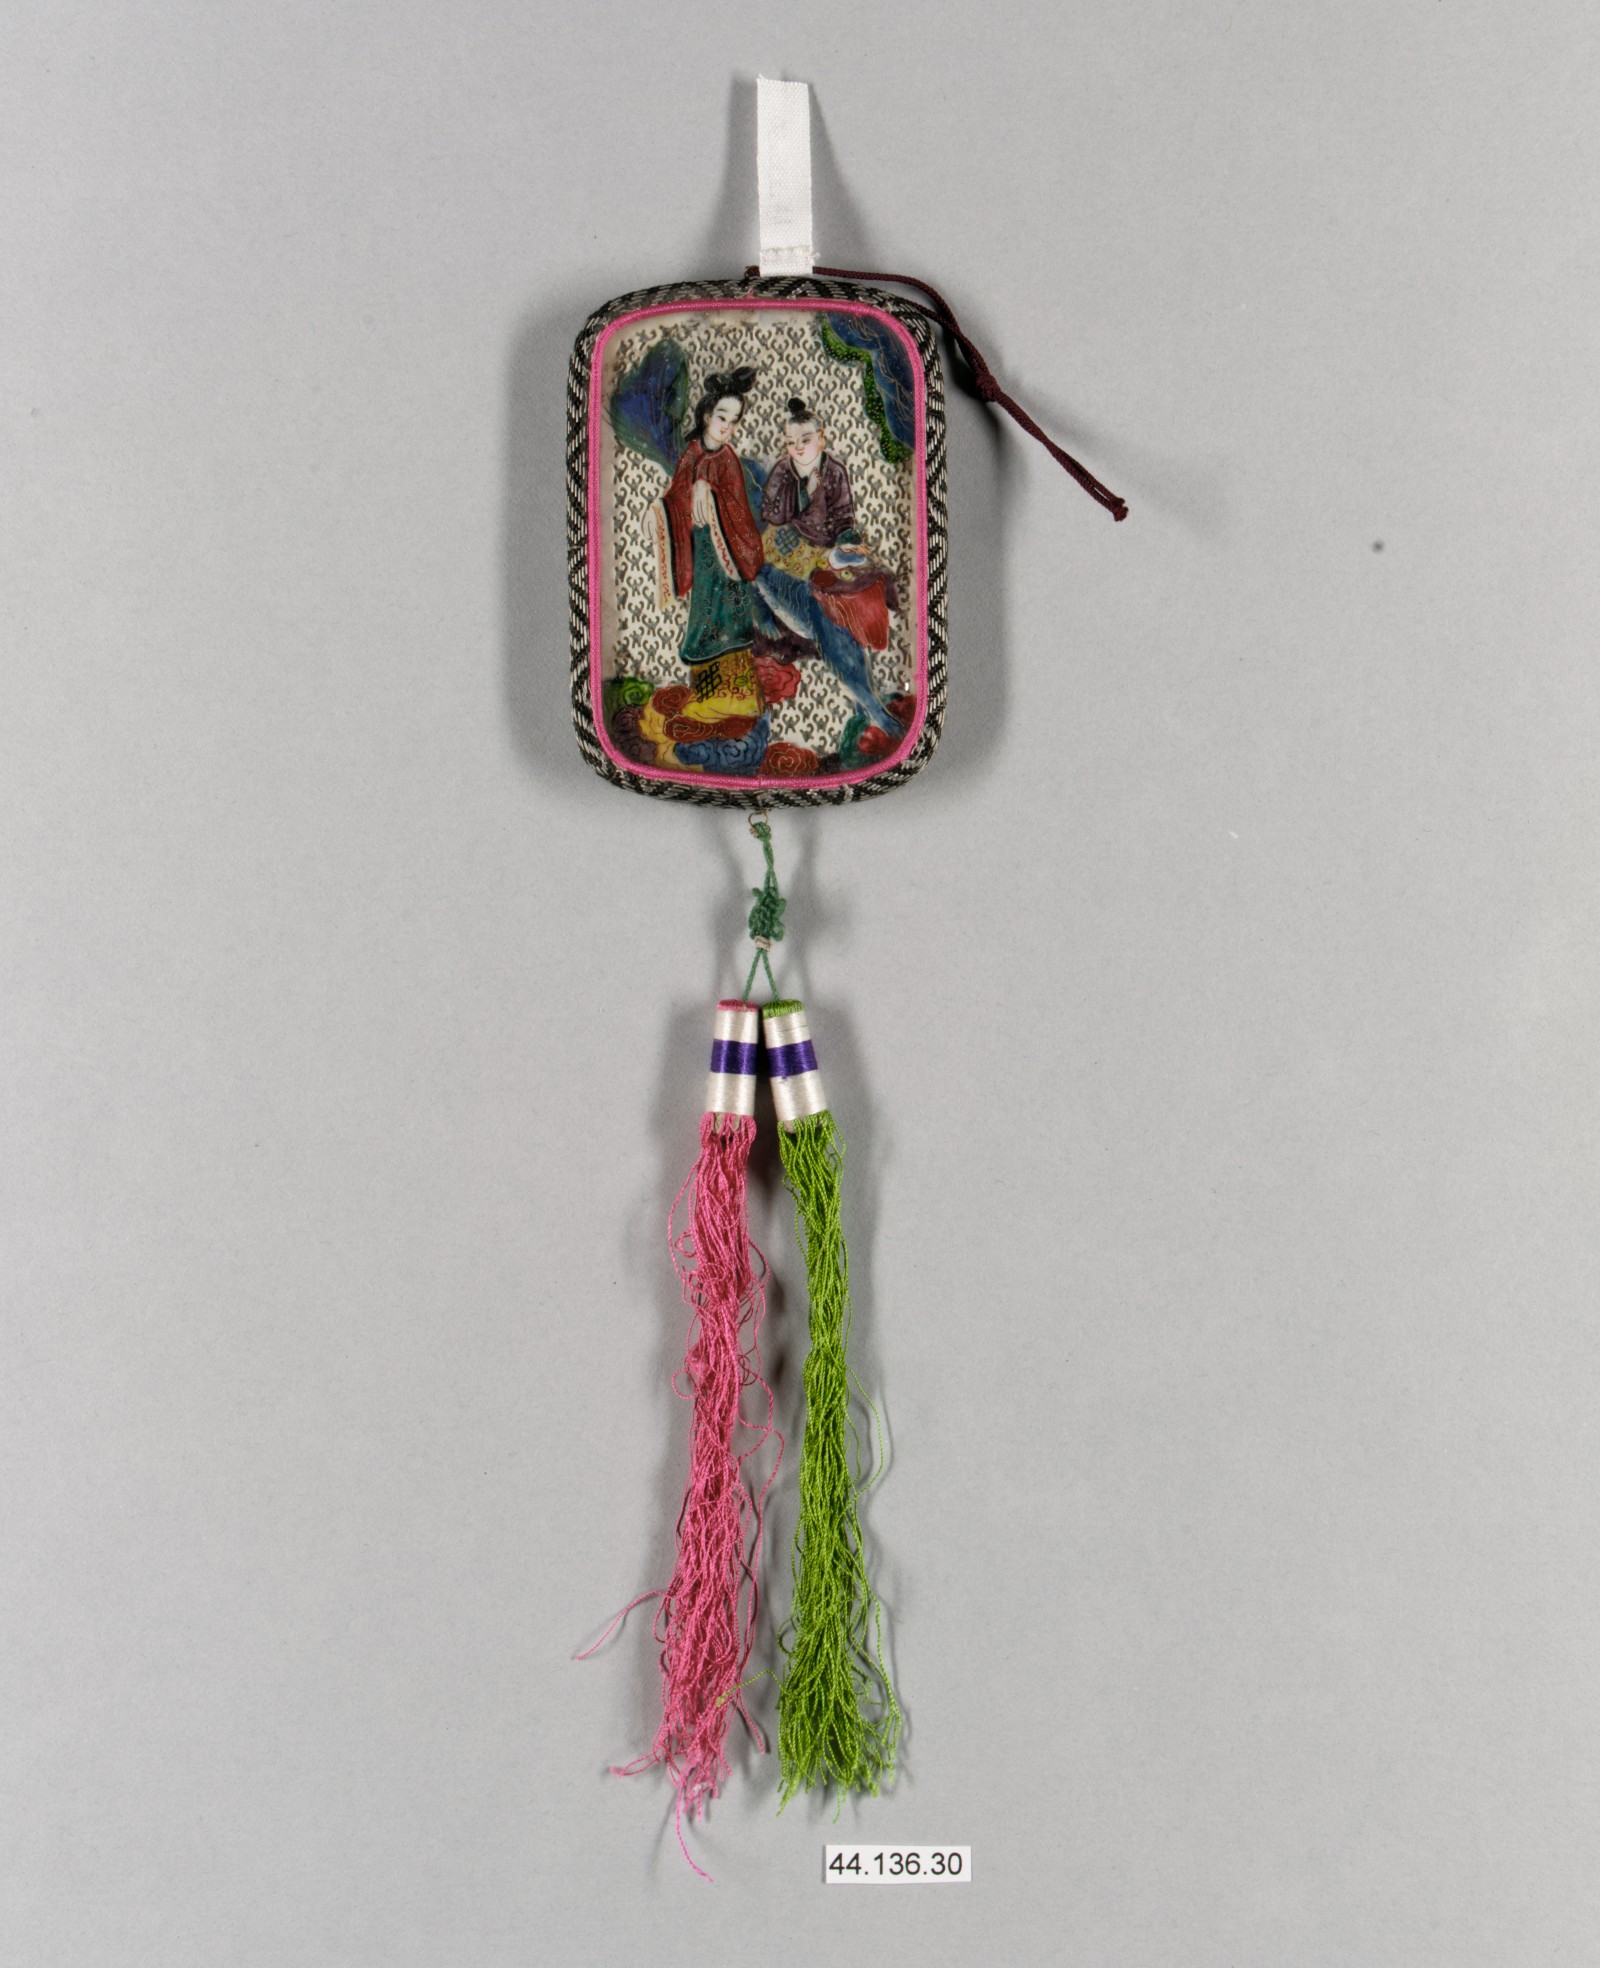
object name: mirror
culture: chinese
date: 1801-1900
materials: glass, ivory, silk